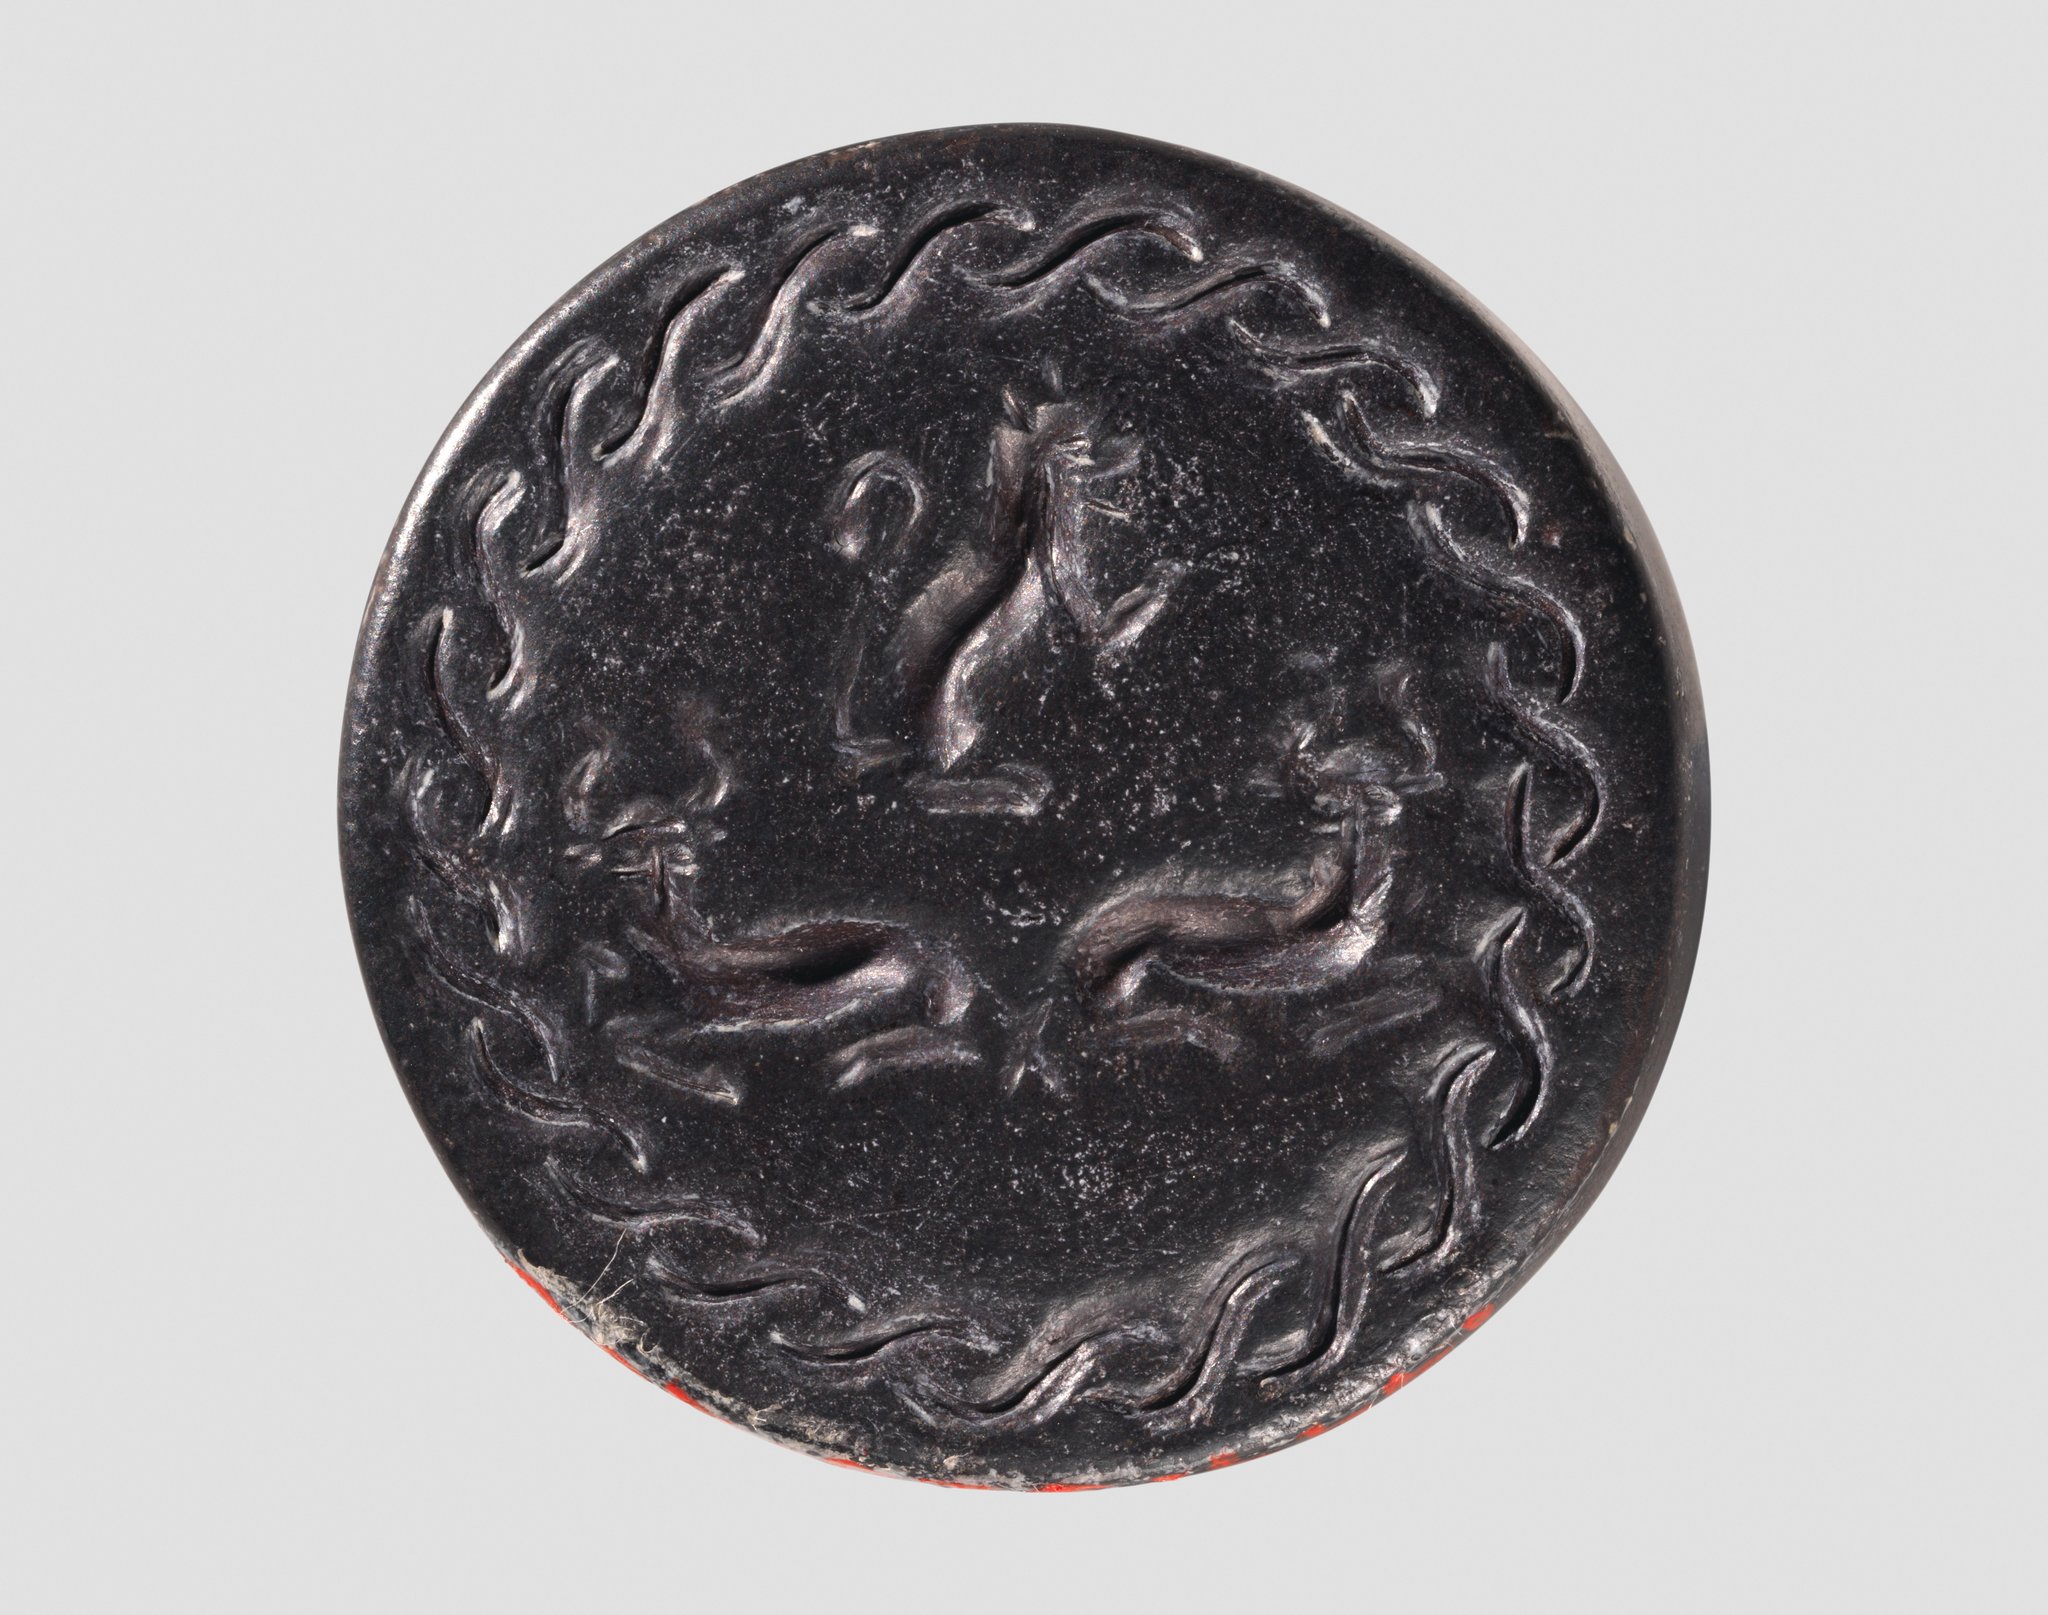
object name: stamp seal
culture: hittite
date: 1700-1501 BCE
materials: mineral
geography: anatolia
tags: deer,dogs